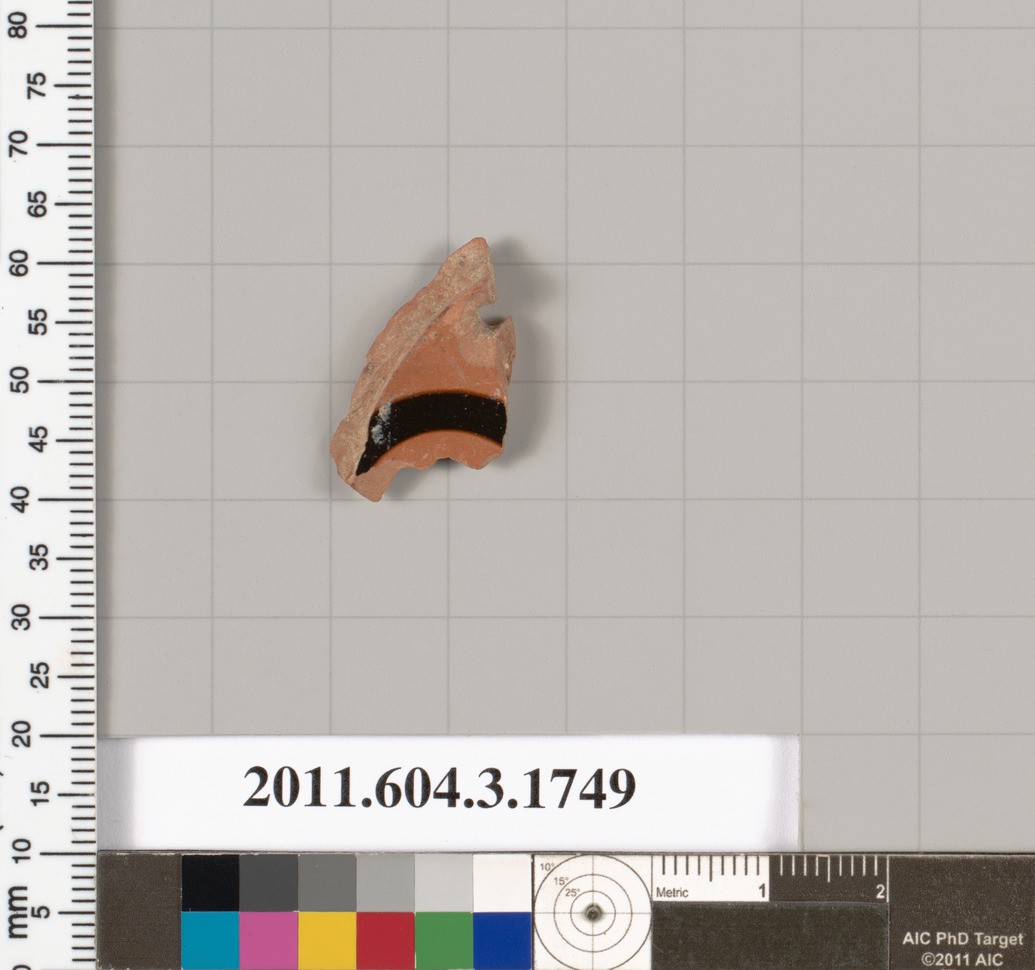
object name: kylix fragment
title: Terracotta fragment of a kylix: Band or lip cup (drinking cup)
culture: greek, attic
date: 550-526 BCE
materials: terracotta